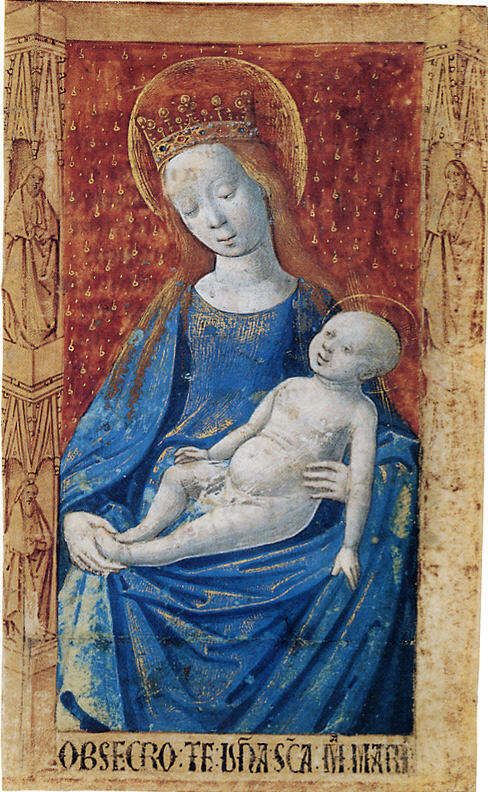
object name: leaf from a book of hour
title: Virgin and Child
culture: french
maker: master of guillaume lambert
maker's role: artist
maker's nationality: french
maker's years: 1480-1490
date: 1485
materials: gold leaf, parchment, paint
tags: madonna and child